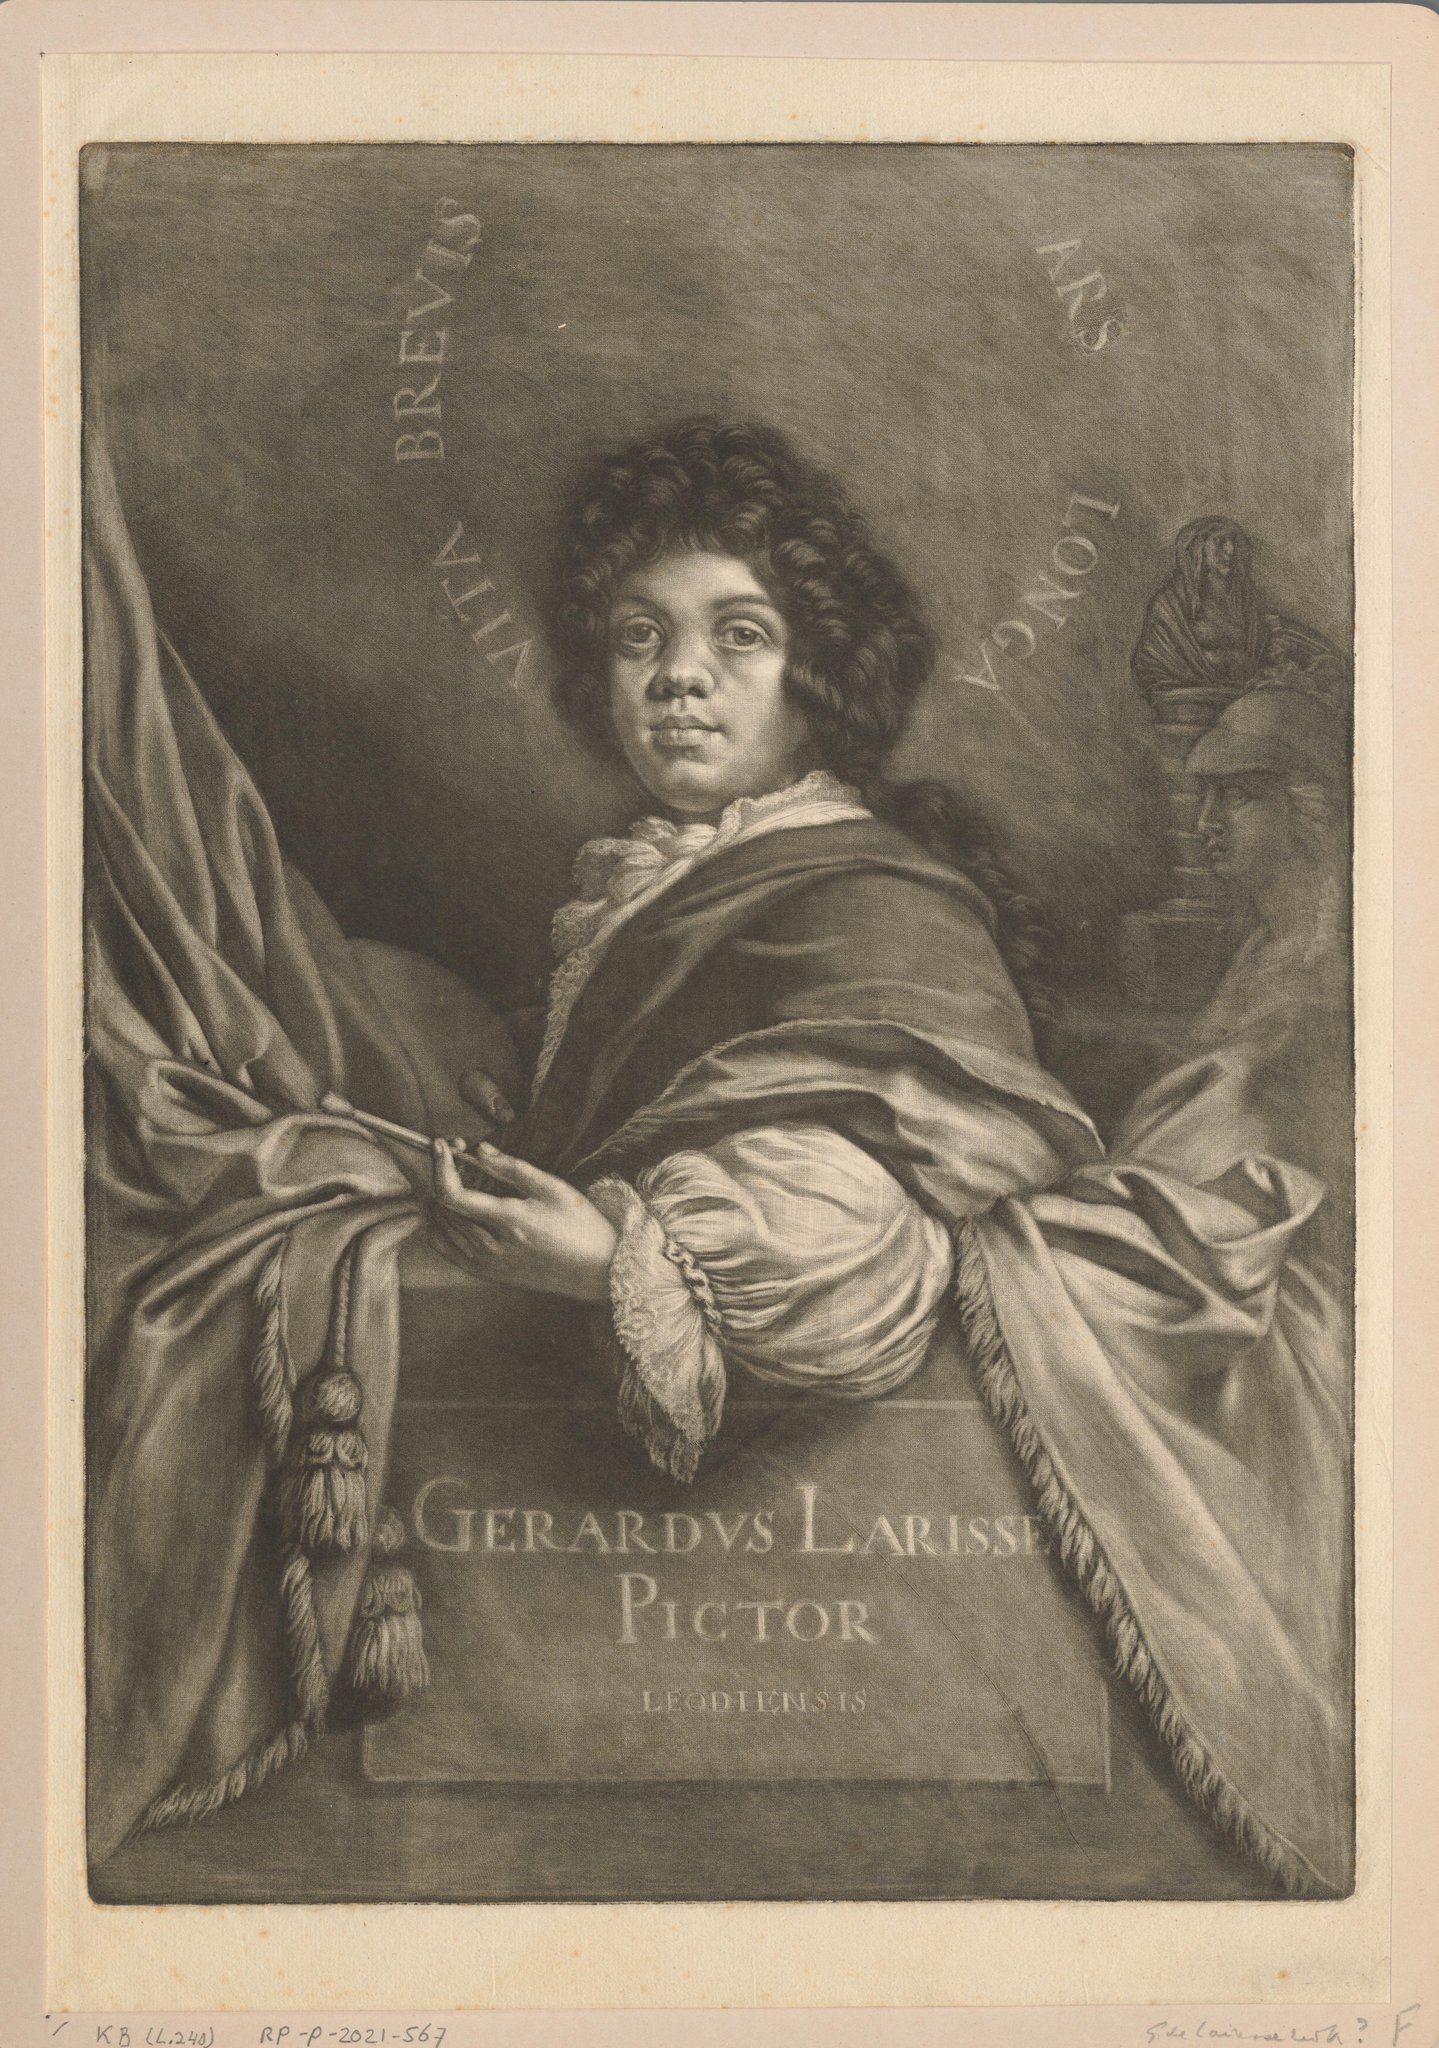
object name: print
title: Portret van Gerard de Lairesse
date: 1665-1711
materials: paper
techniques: mezzotint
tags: liège, amsterdam, painter, print maker, draughtsman, gerard de lairesse, historical persons, portrait, self-portrait of painter, brushes ~ implements of painter, sculpture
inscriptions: collector's mark: Lugt 240